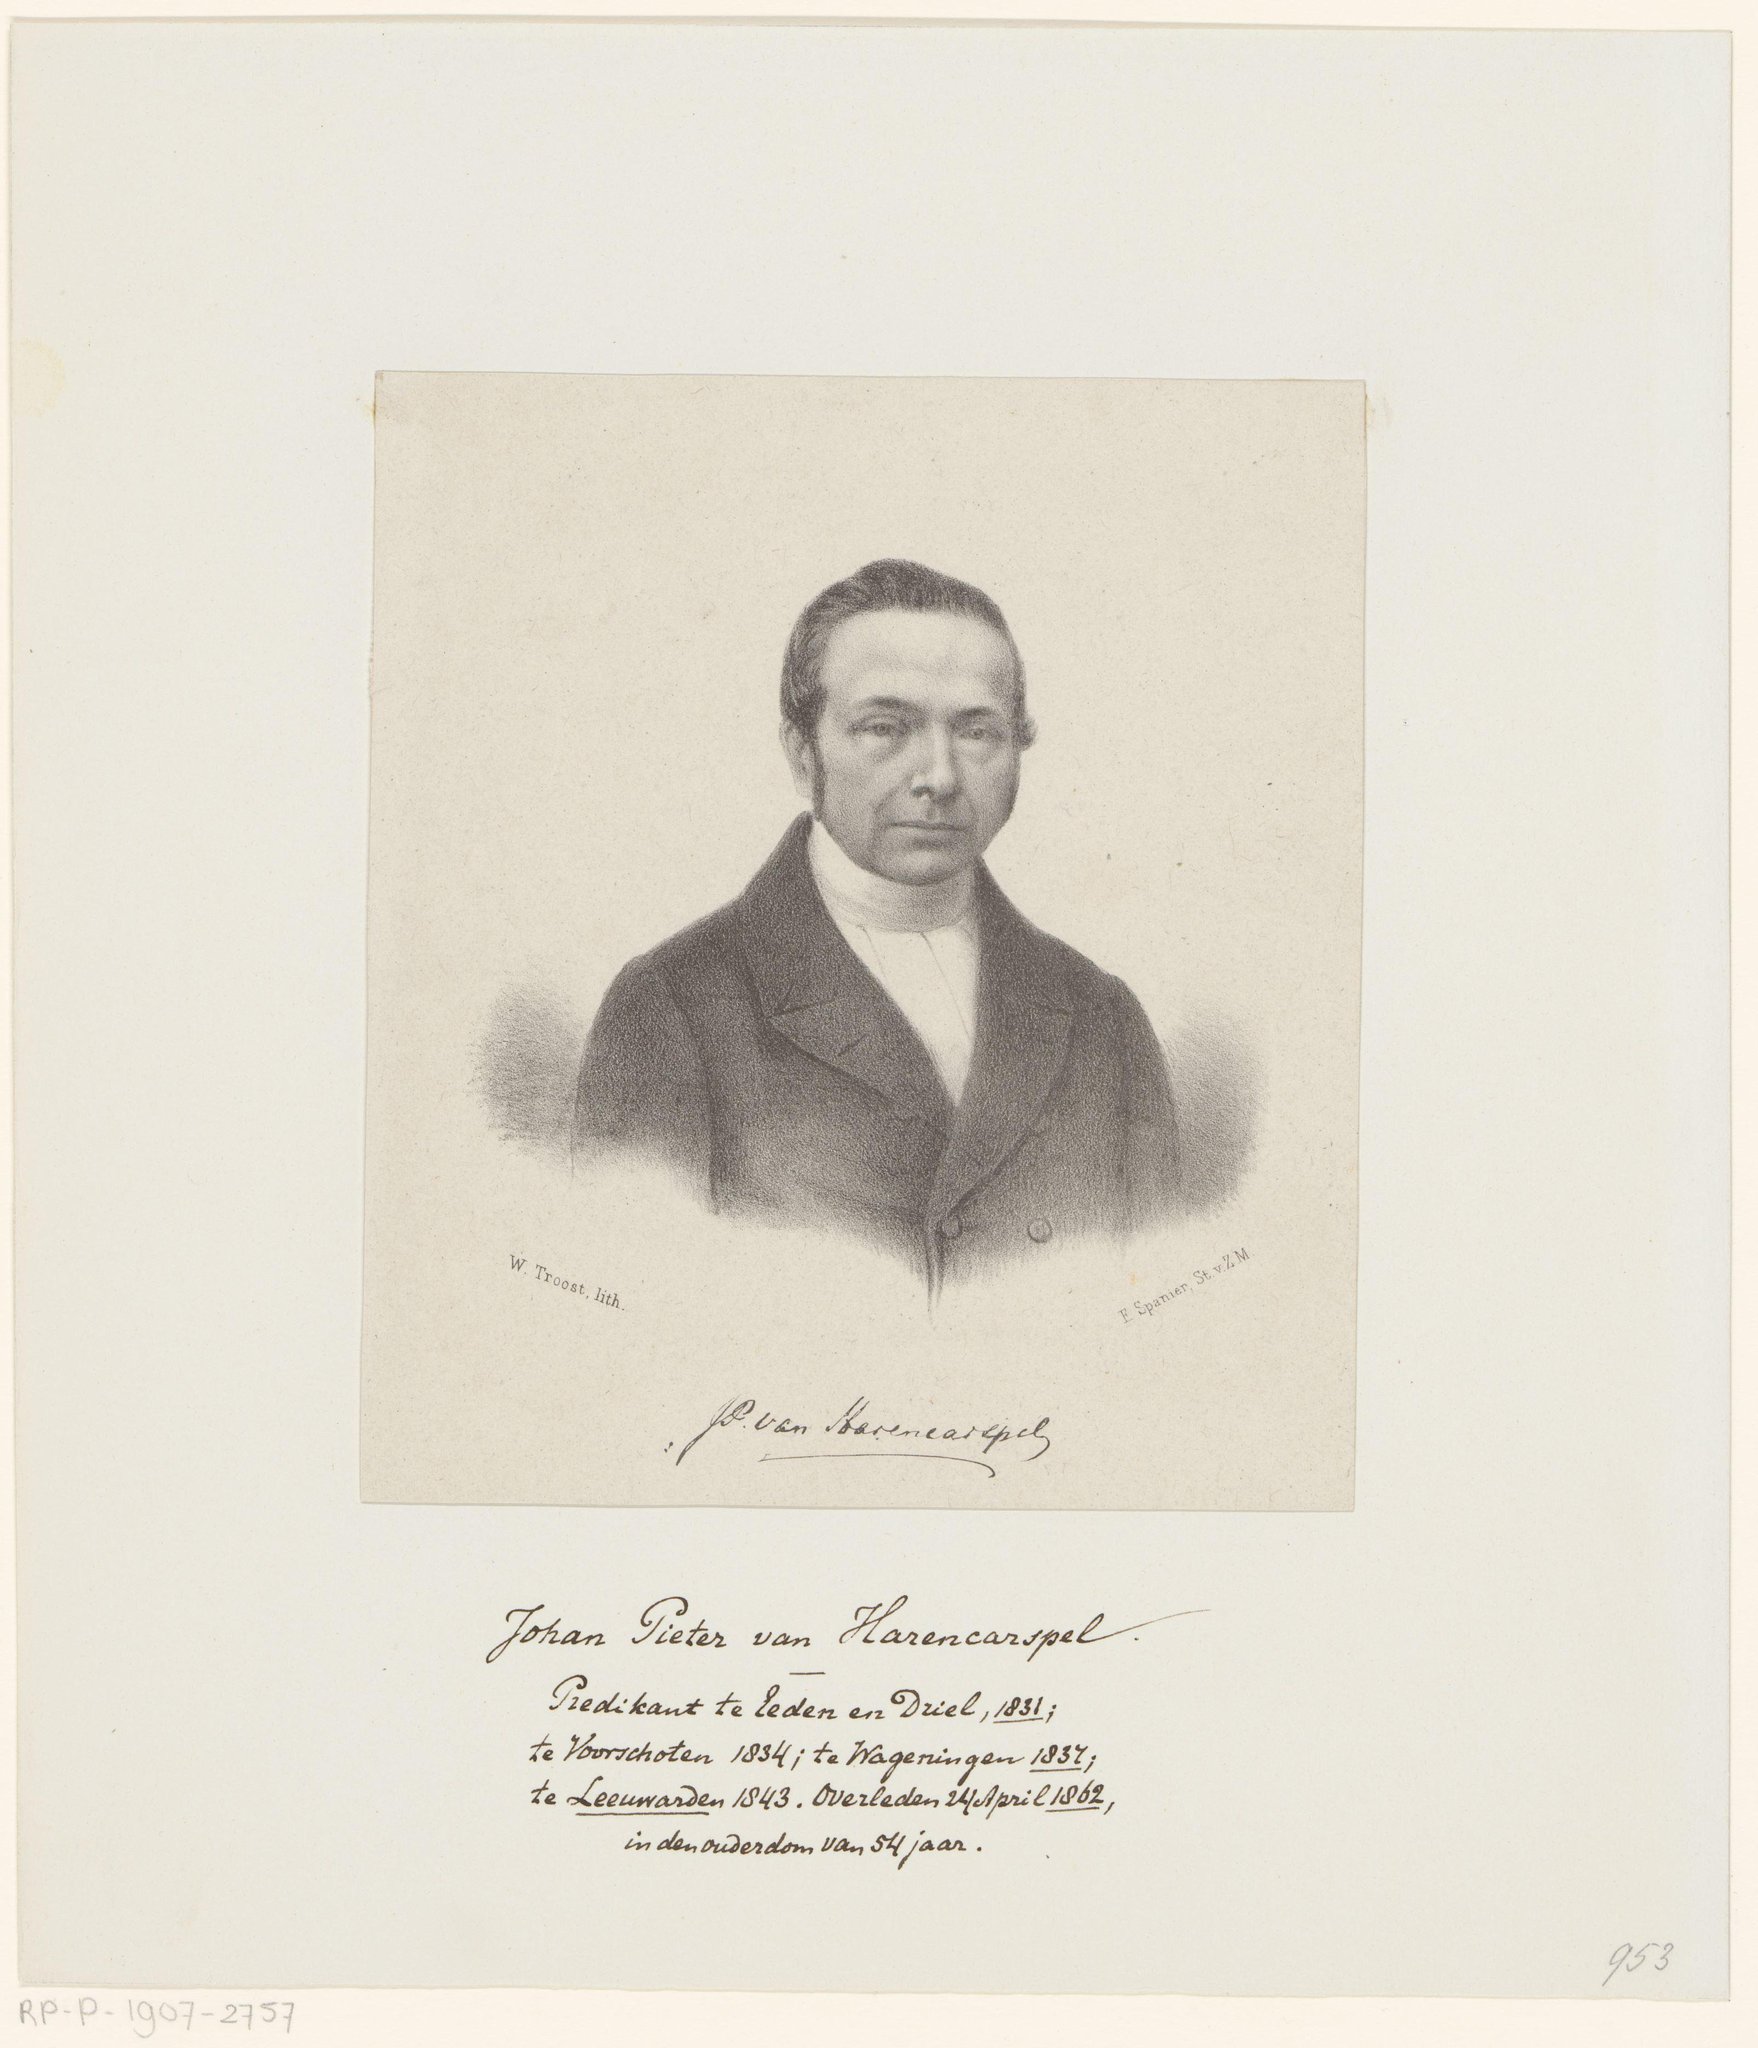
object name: print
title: Portret van Johan Pieter van Harencarspel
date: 1831-1862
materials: paper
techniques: lithograph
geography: the hague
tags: historical persons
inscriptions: collector's mark: Lugt 2228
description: Onder het portret de signatuur van de geportretteerde.